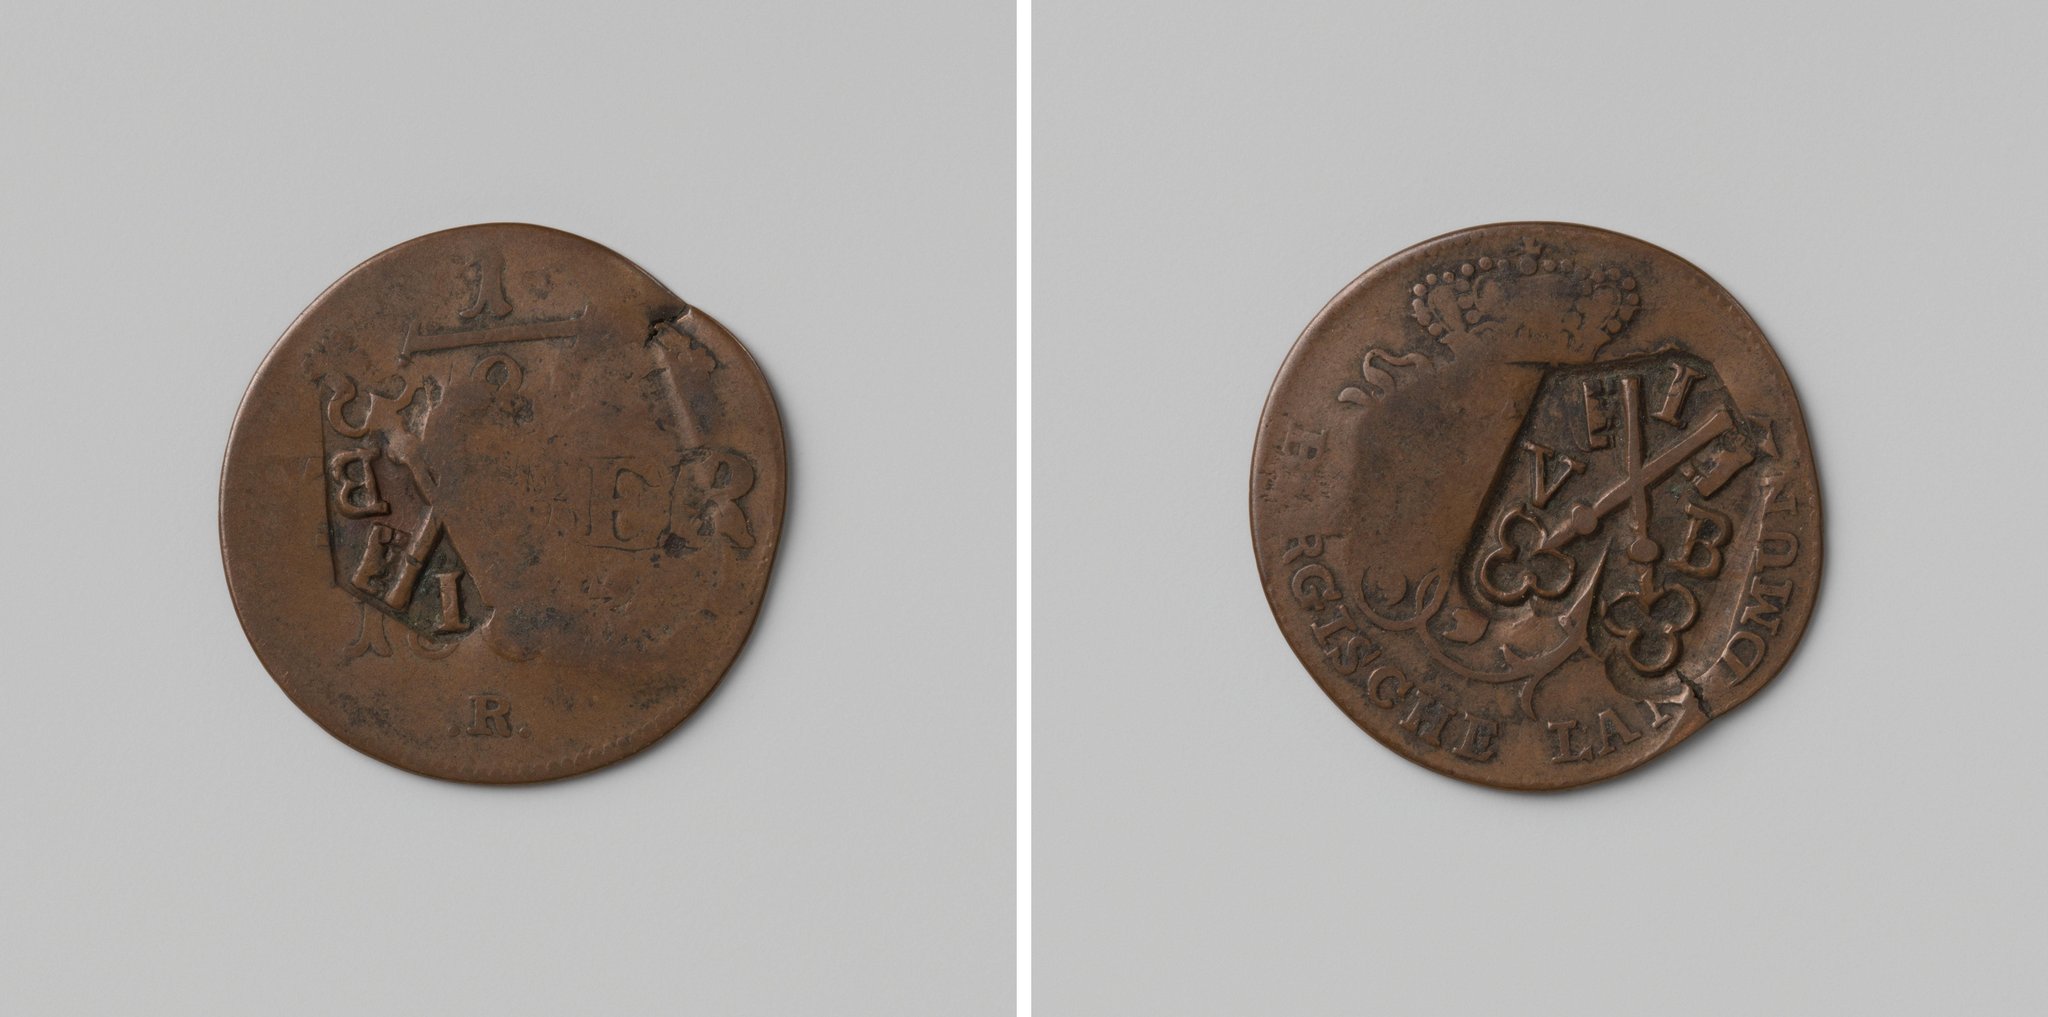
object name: coin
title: Munt van een halve stuiver van lakenloodje van Leiden, vervaardigd uit een 'Bergische Landesmunze' ter waarde van een halve stuiver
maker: Anonymous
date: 1800-1882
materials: copper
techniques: striking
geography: germany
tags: leiden